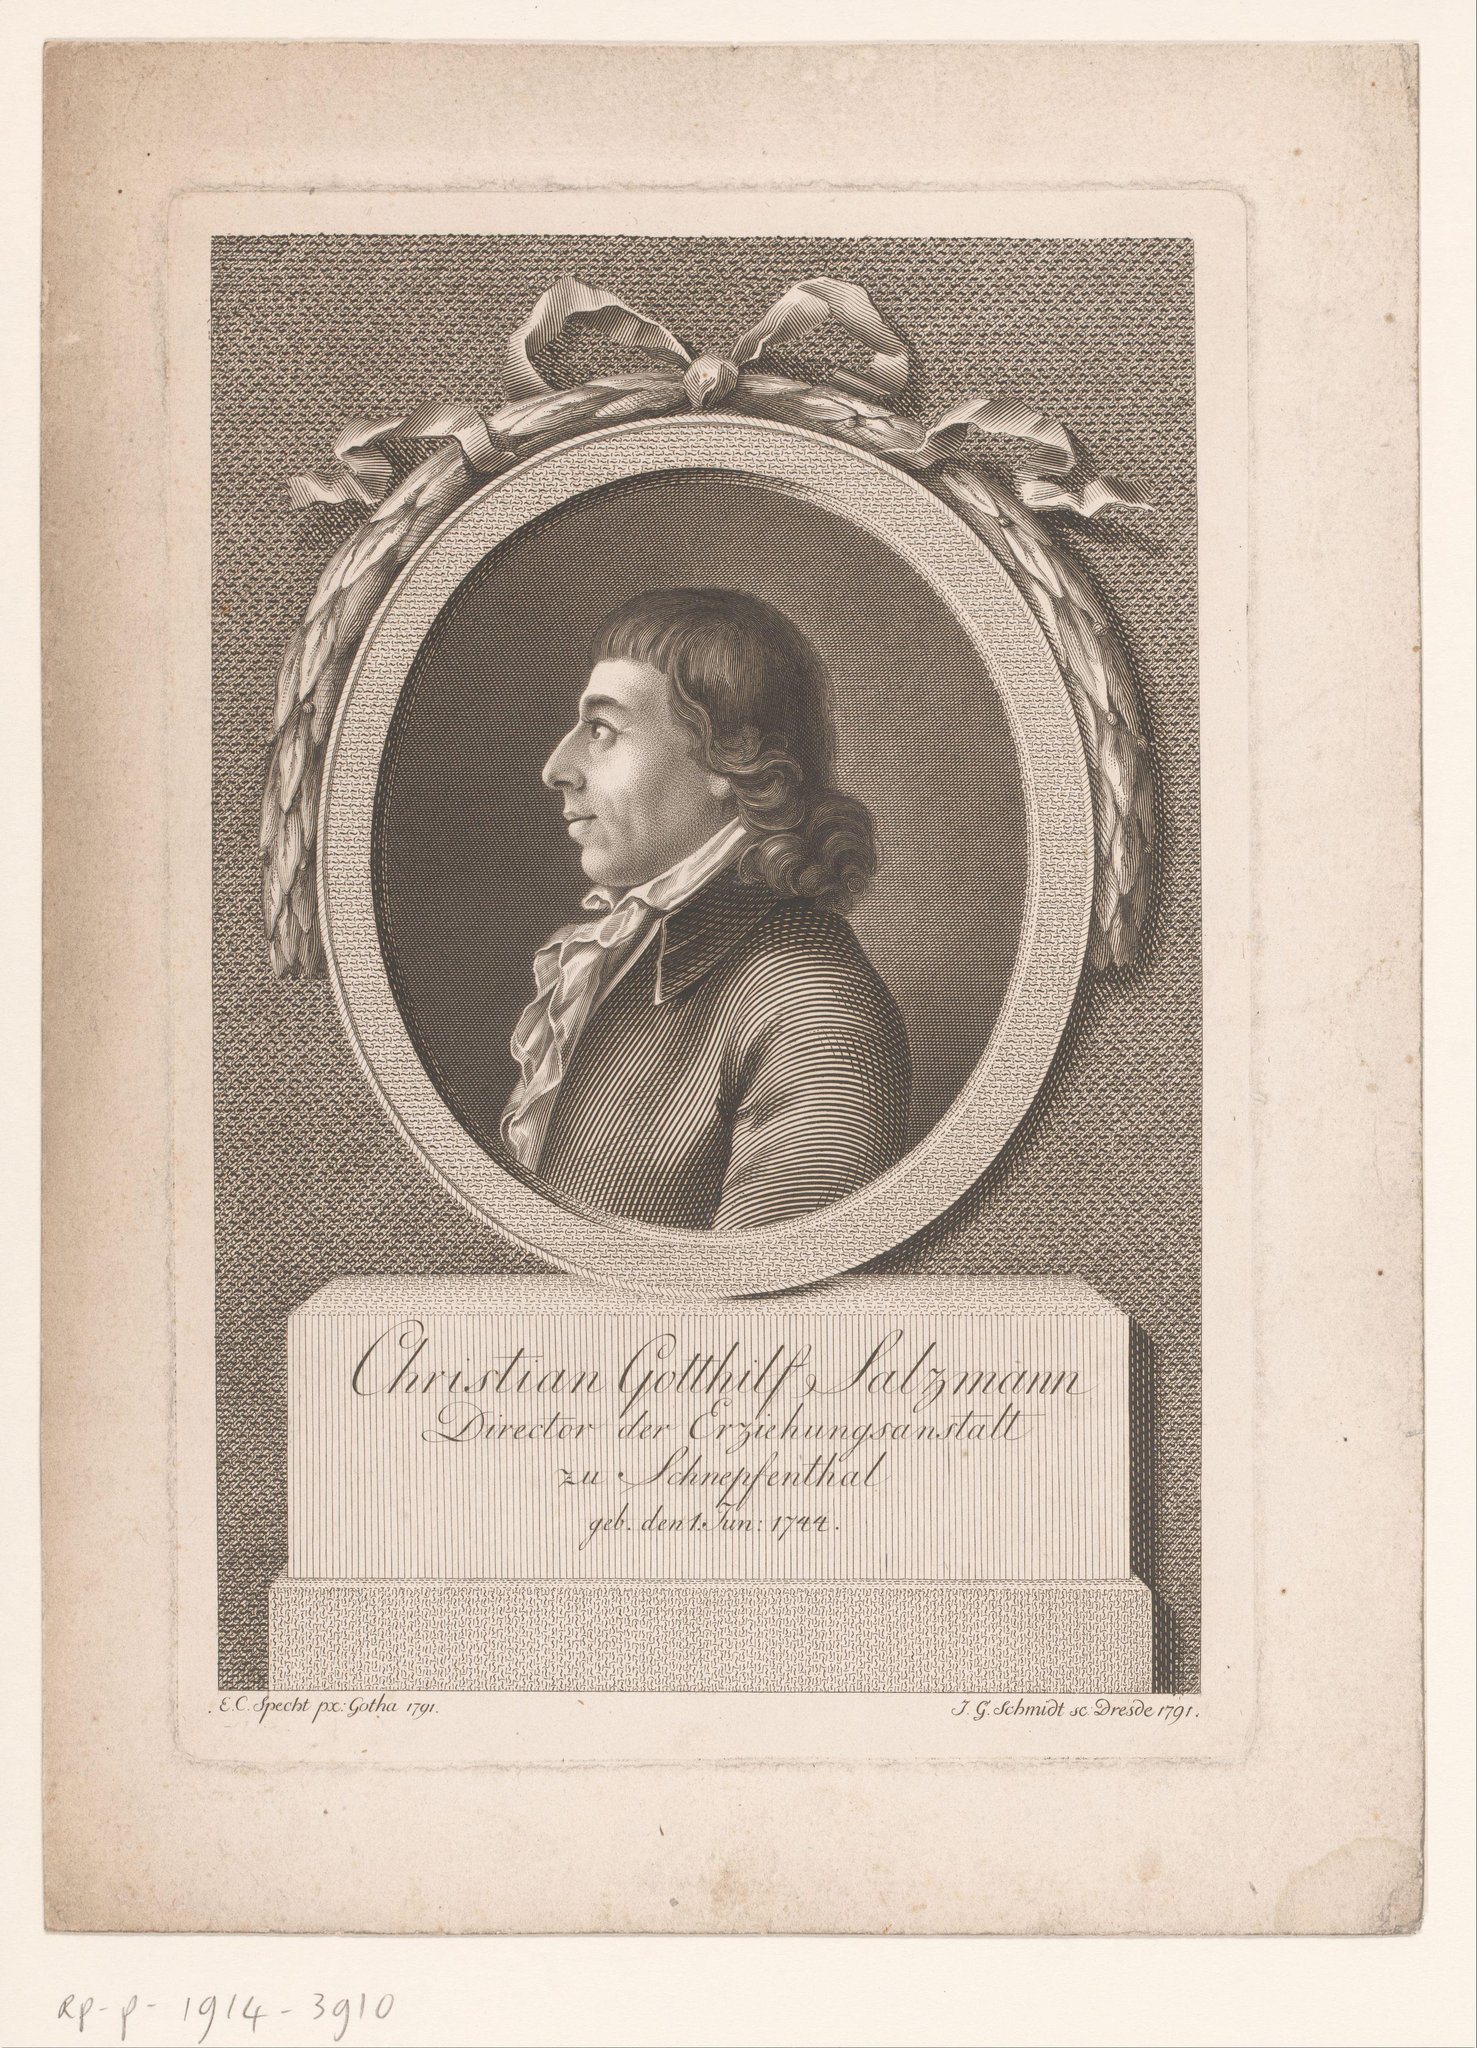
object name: print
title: Portret van Christian Gotthilf Salzmann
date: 1791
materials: paper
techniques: engraving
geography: dresden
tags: historical persons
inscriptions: collector's mark: Lugt 2228